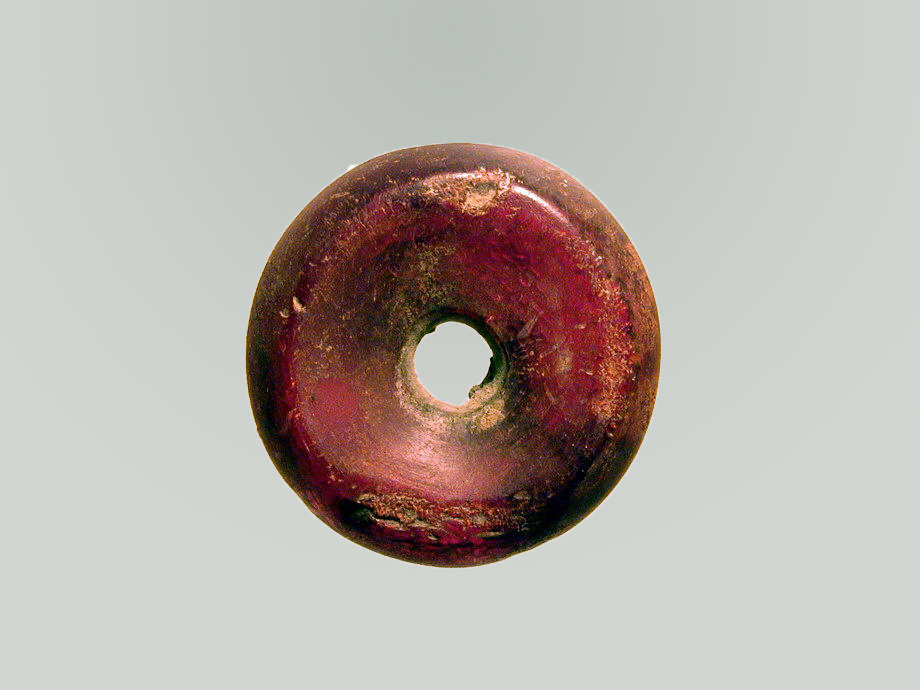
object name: whorl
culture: etruscan or italic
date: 700-601 BCE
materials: amber